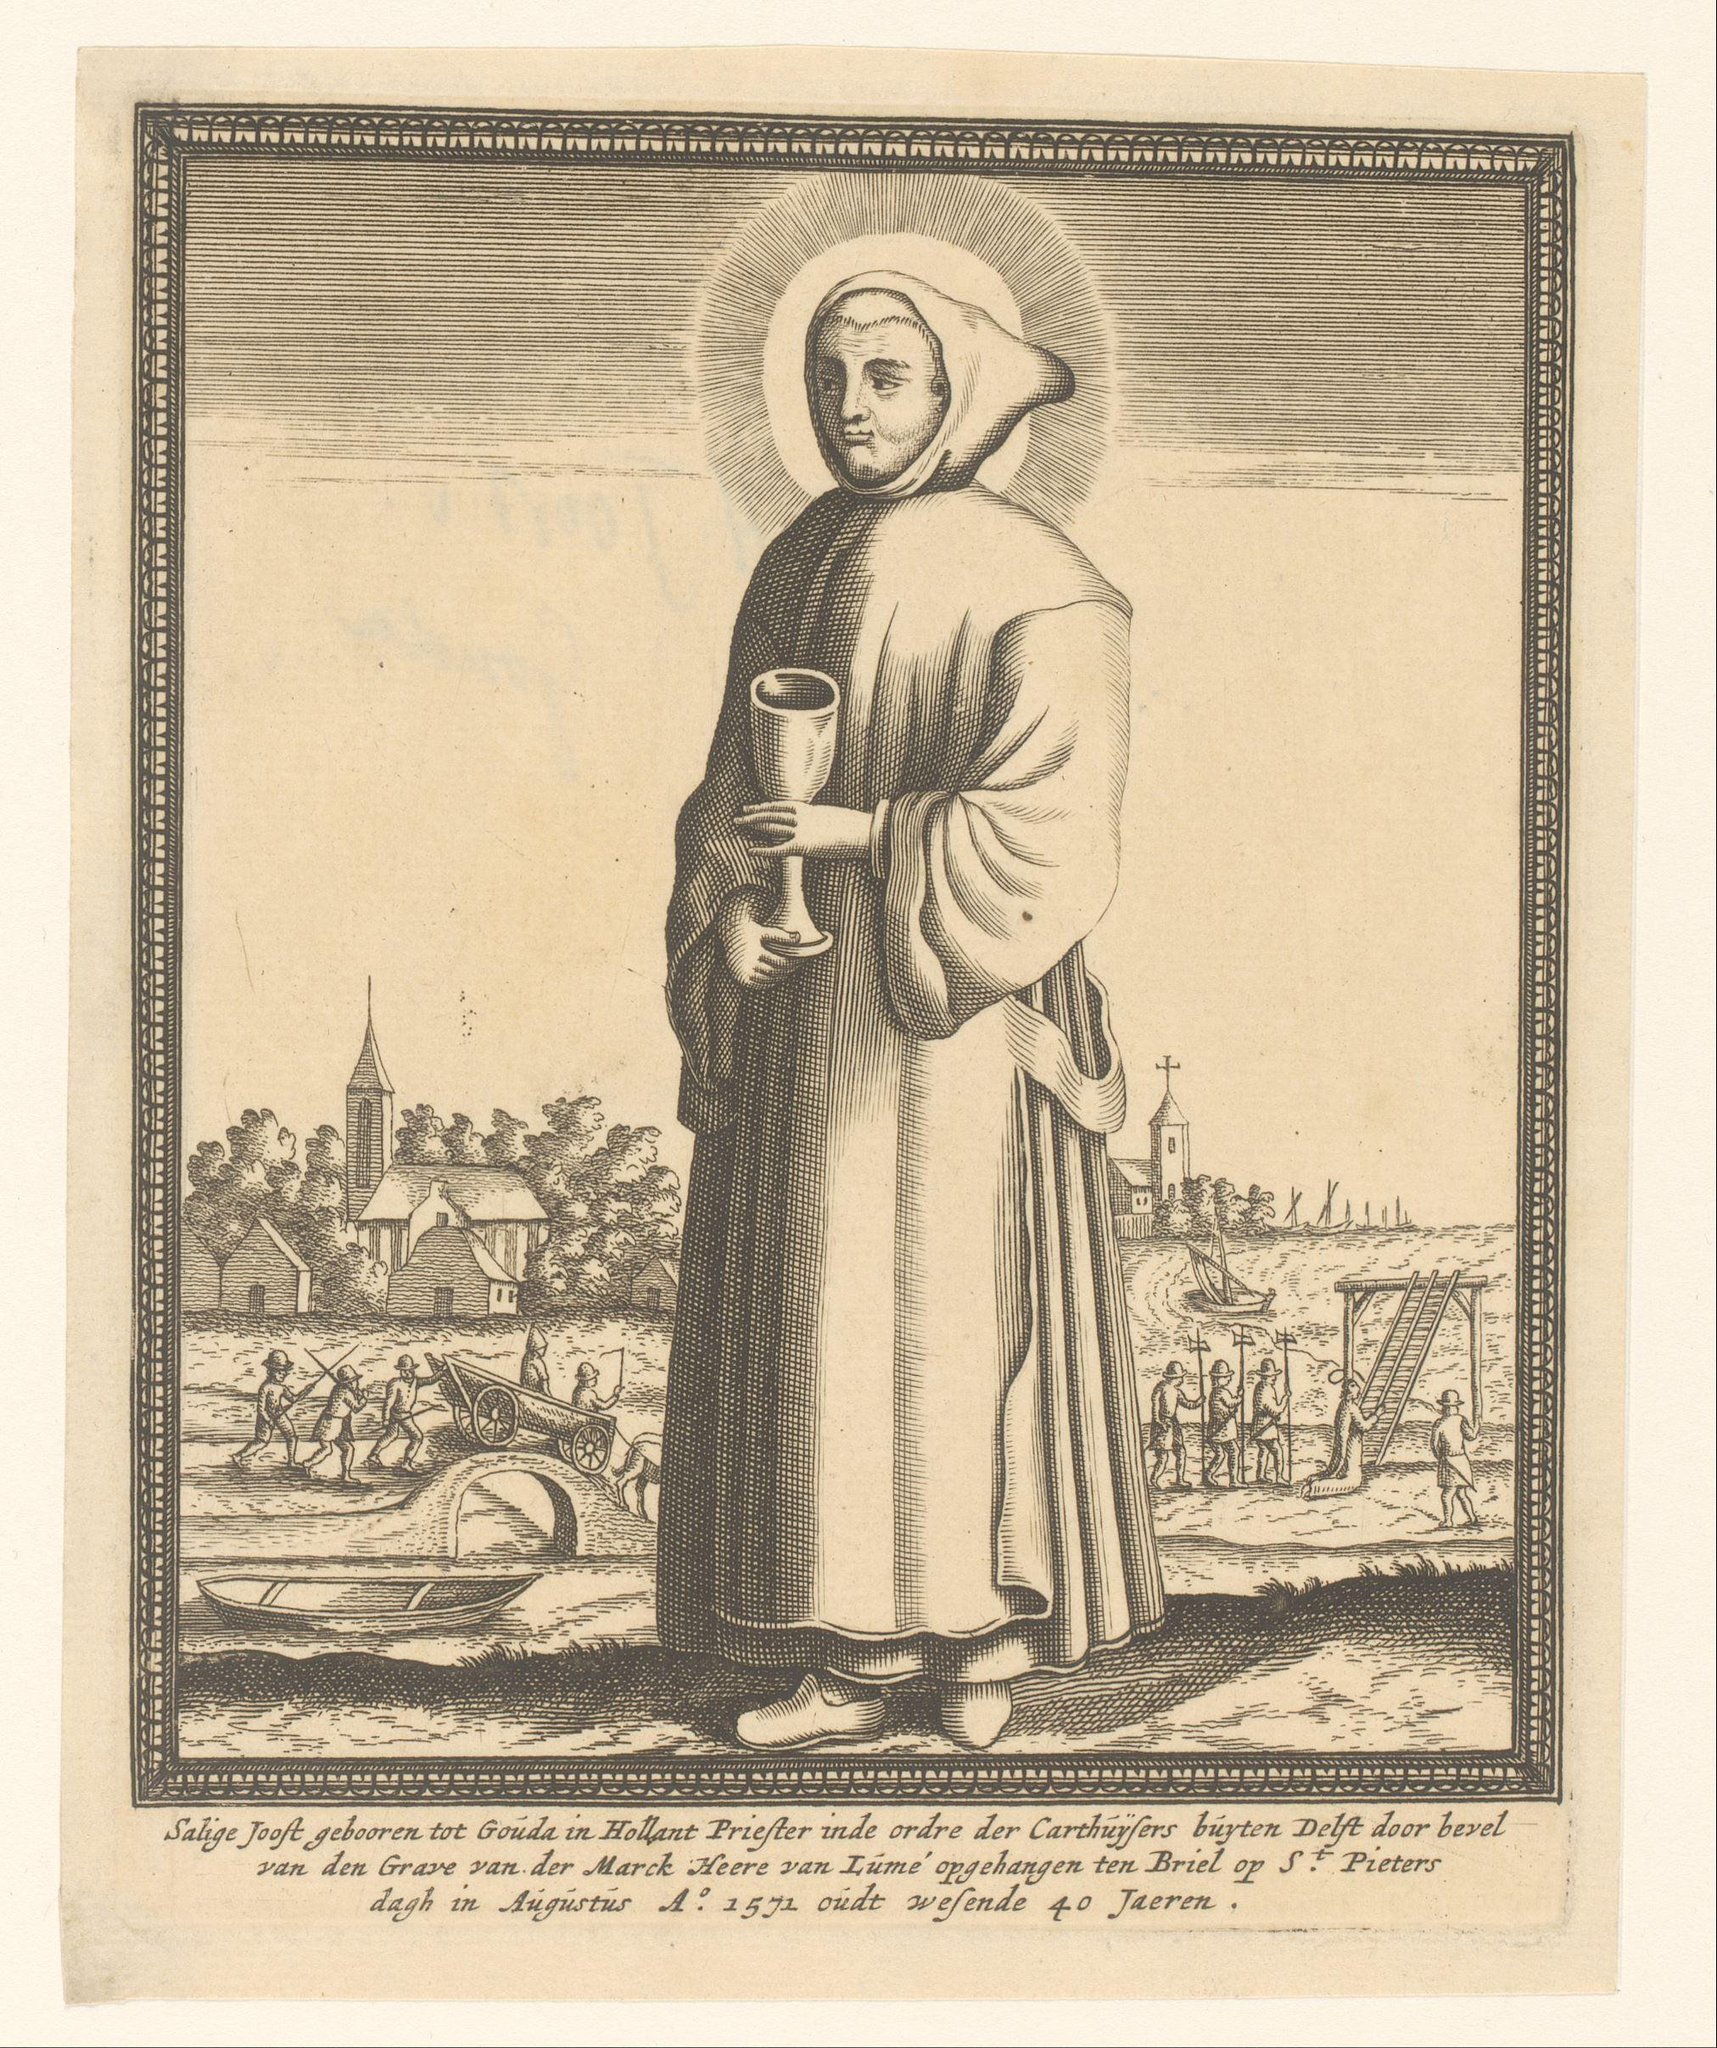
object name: print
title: Salige Joost gebooren tot Gouda (...)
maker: Anonymous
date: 1667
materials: paper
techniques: engraving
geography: low countries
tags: gouda, priest, priest (roman catholic), violent death, being killed; being mishandled and maltreated; seeking death (+ death by martyrdom), brielle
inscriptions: collector's mark: Lugt 2228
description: Prent mogelijk uit: Bleyswijck, Dirk Evertsz. Beschryvinge der stadt Delft, betreffende des selfs situatie, oorsprong en ouderdom, opkomst en voortgangh (…). Delft: Arnold Bon, 1667.